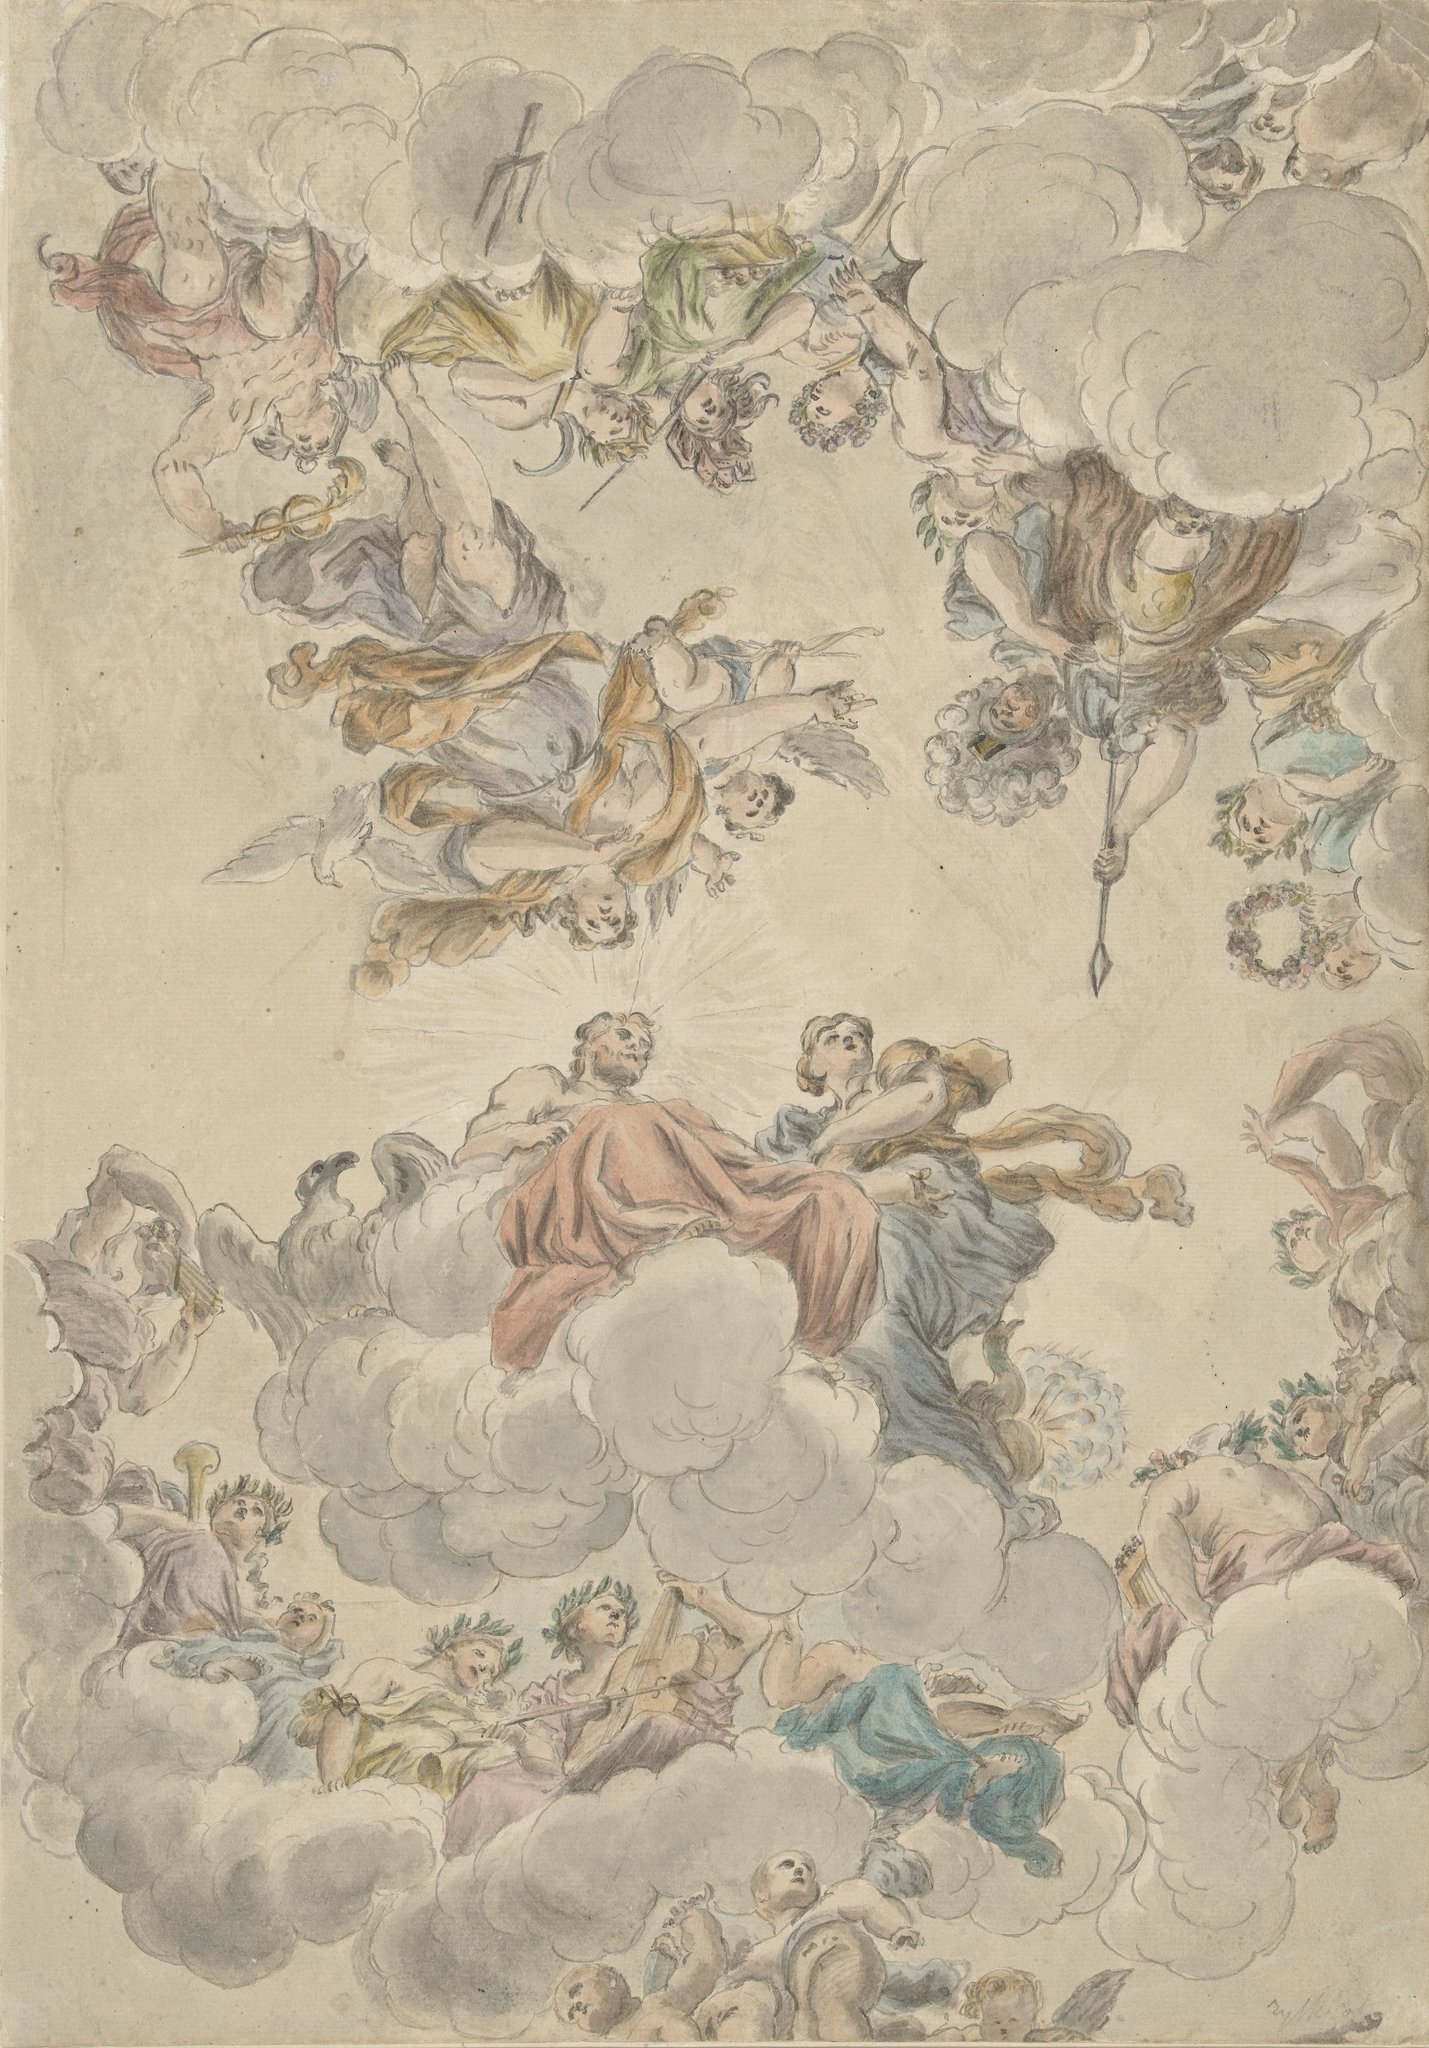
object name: drawing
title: Ontwerp voor een plafond met het huwelijk van Jupiter en Juno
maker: petrus norbertus van reysschoot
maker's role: draughtsman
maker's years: 1738-1795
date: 1748-1795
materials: paper, watercolor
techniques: brush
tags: jupiter and juno as king and queen of heaven